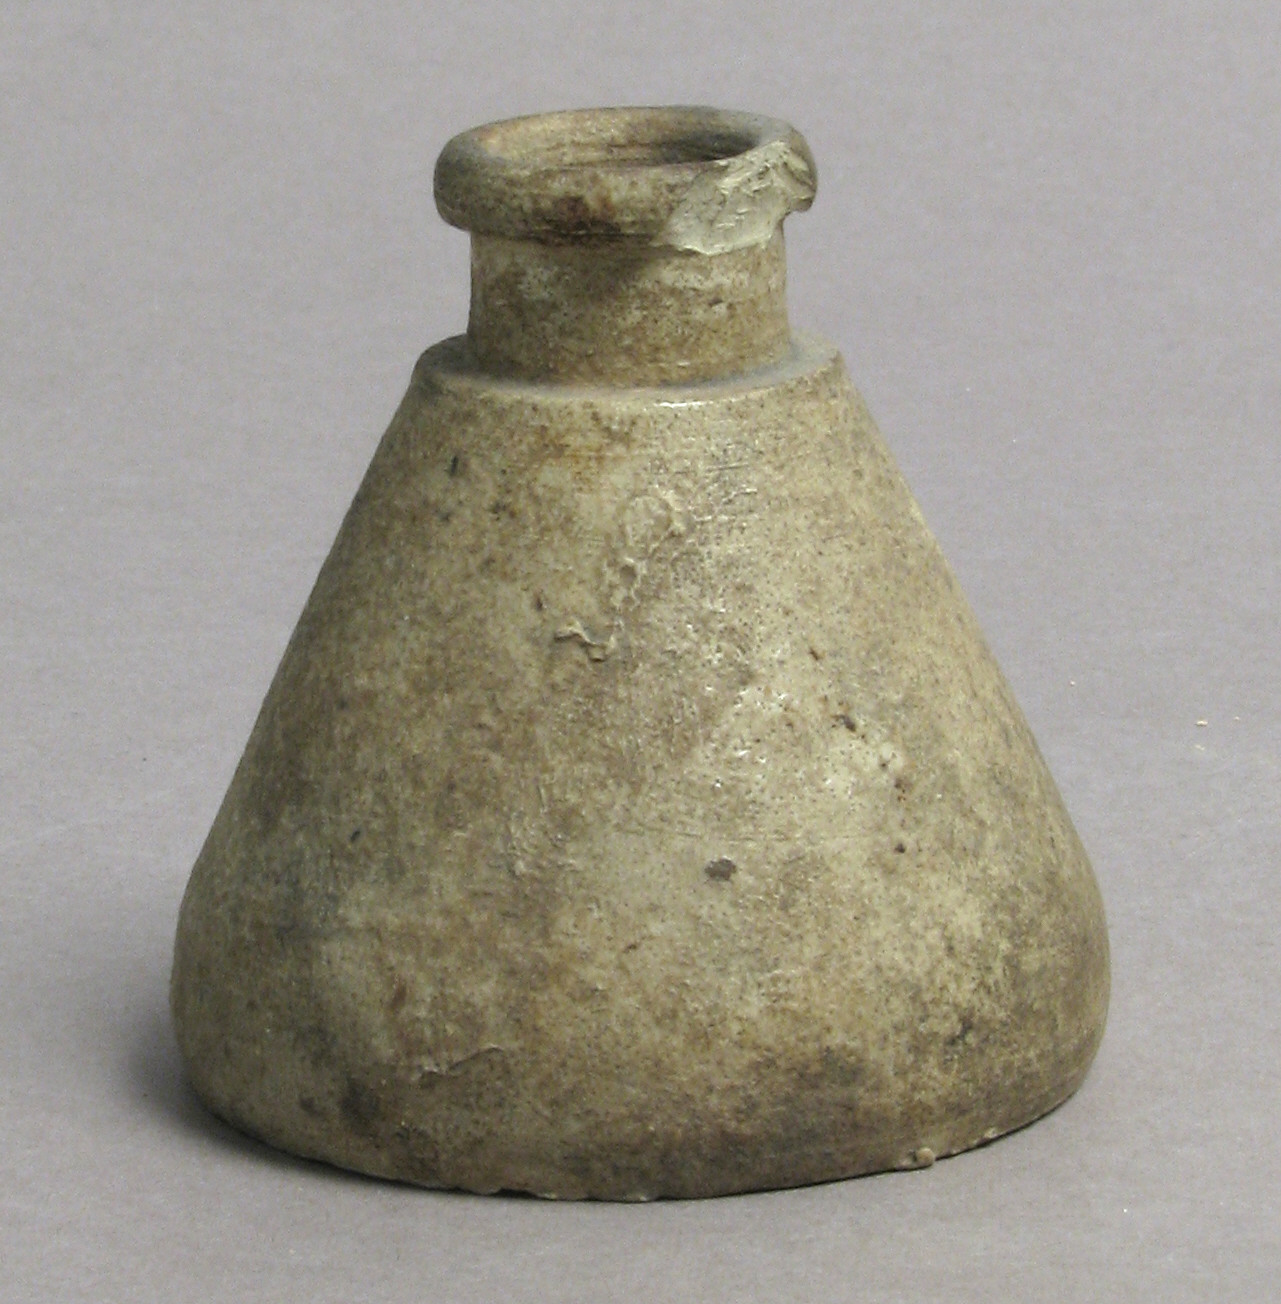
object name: bottle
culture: french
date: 1501-1600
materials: earthenware, glaze